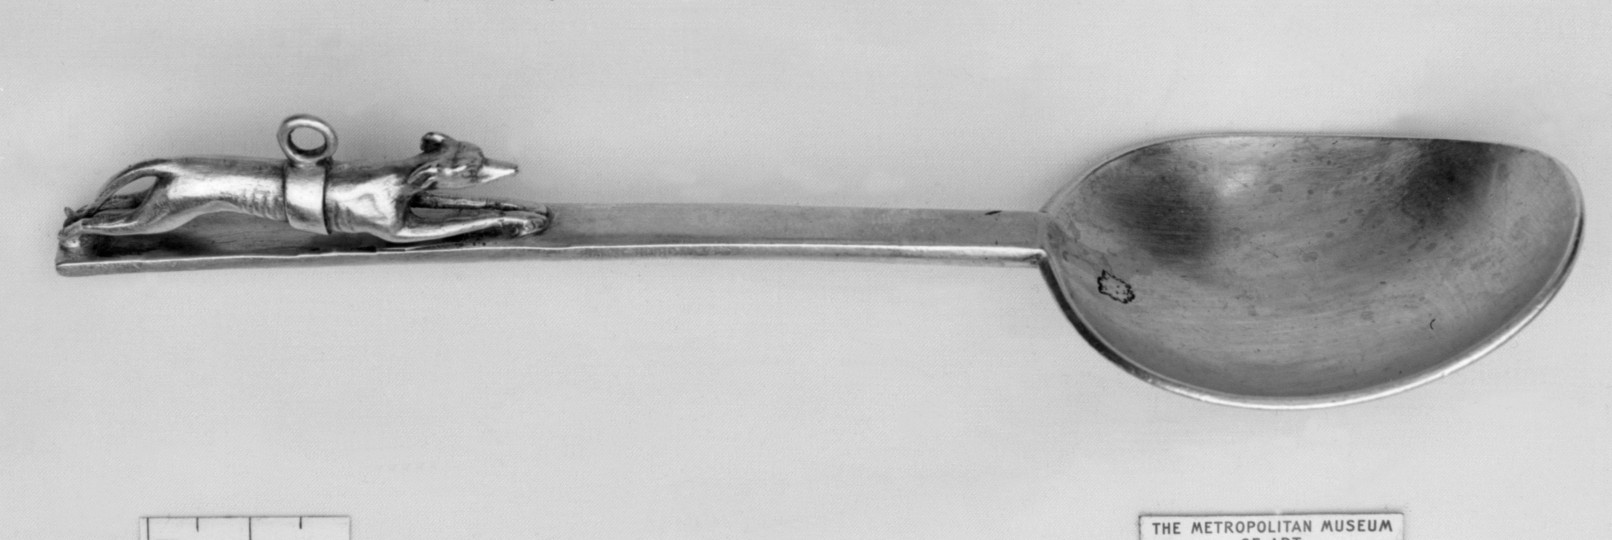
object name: spoon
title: Puritan spoon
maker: stephen venables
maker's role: maker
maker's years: 1635-1688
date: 1652-1653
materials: silver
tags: dogs